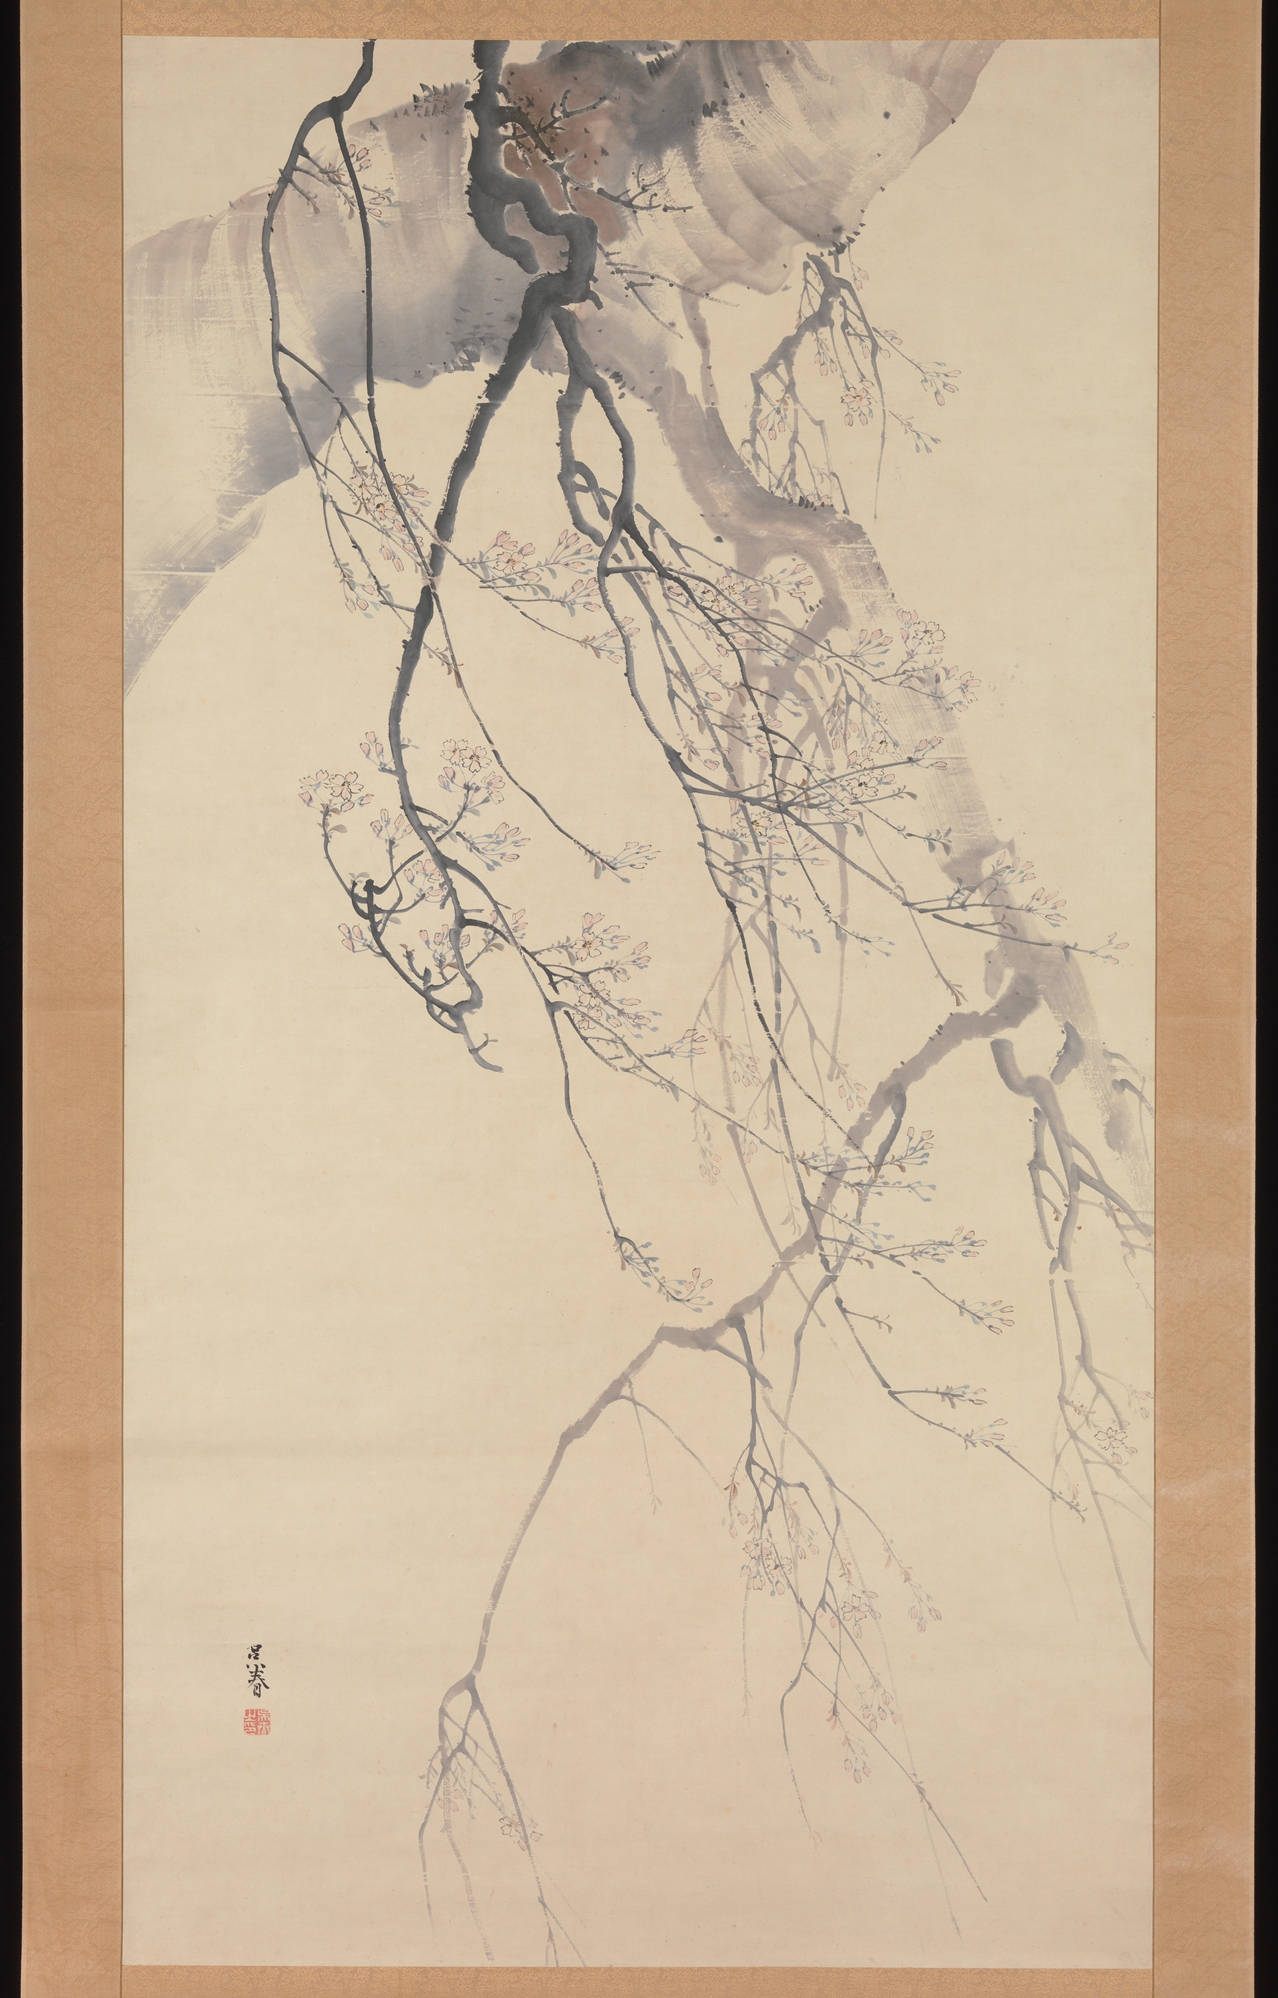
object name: hanging scroll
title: Cherry Blossoms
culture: japanese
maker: matsumura goshun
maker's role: artist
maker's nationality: japanese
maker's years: 1752-1811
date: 1767-1800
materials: ink, paper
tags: trees